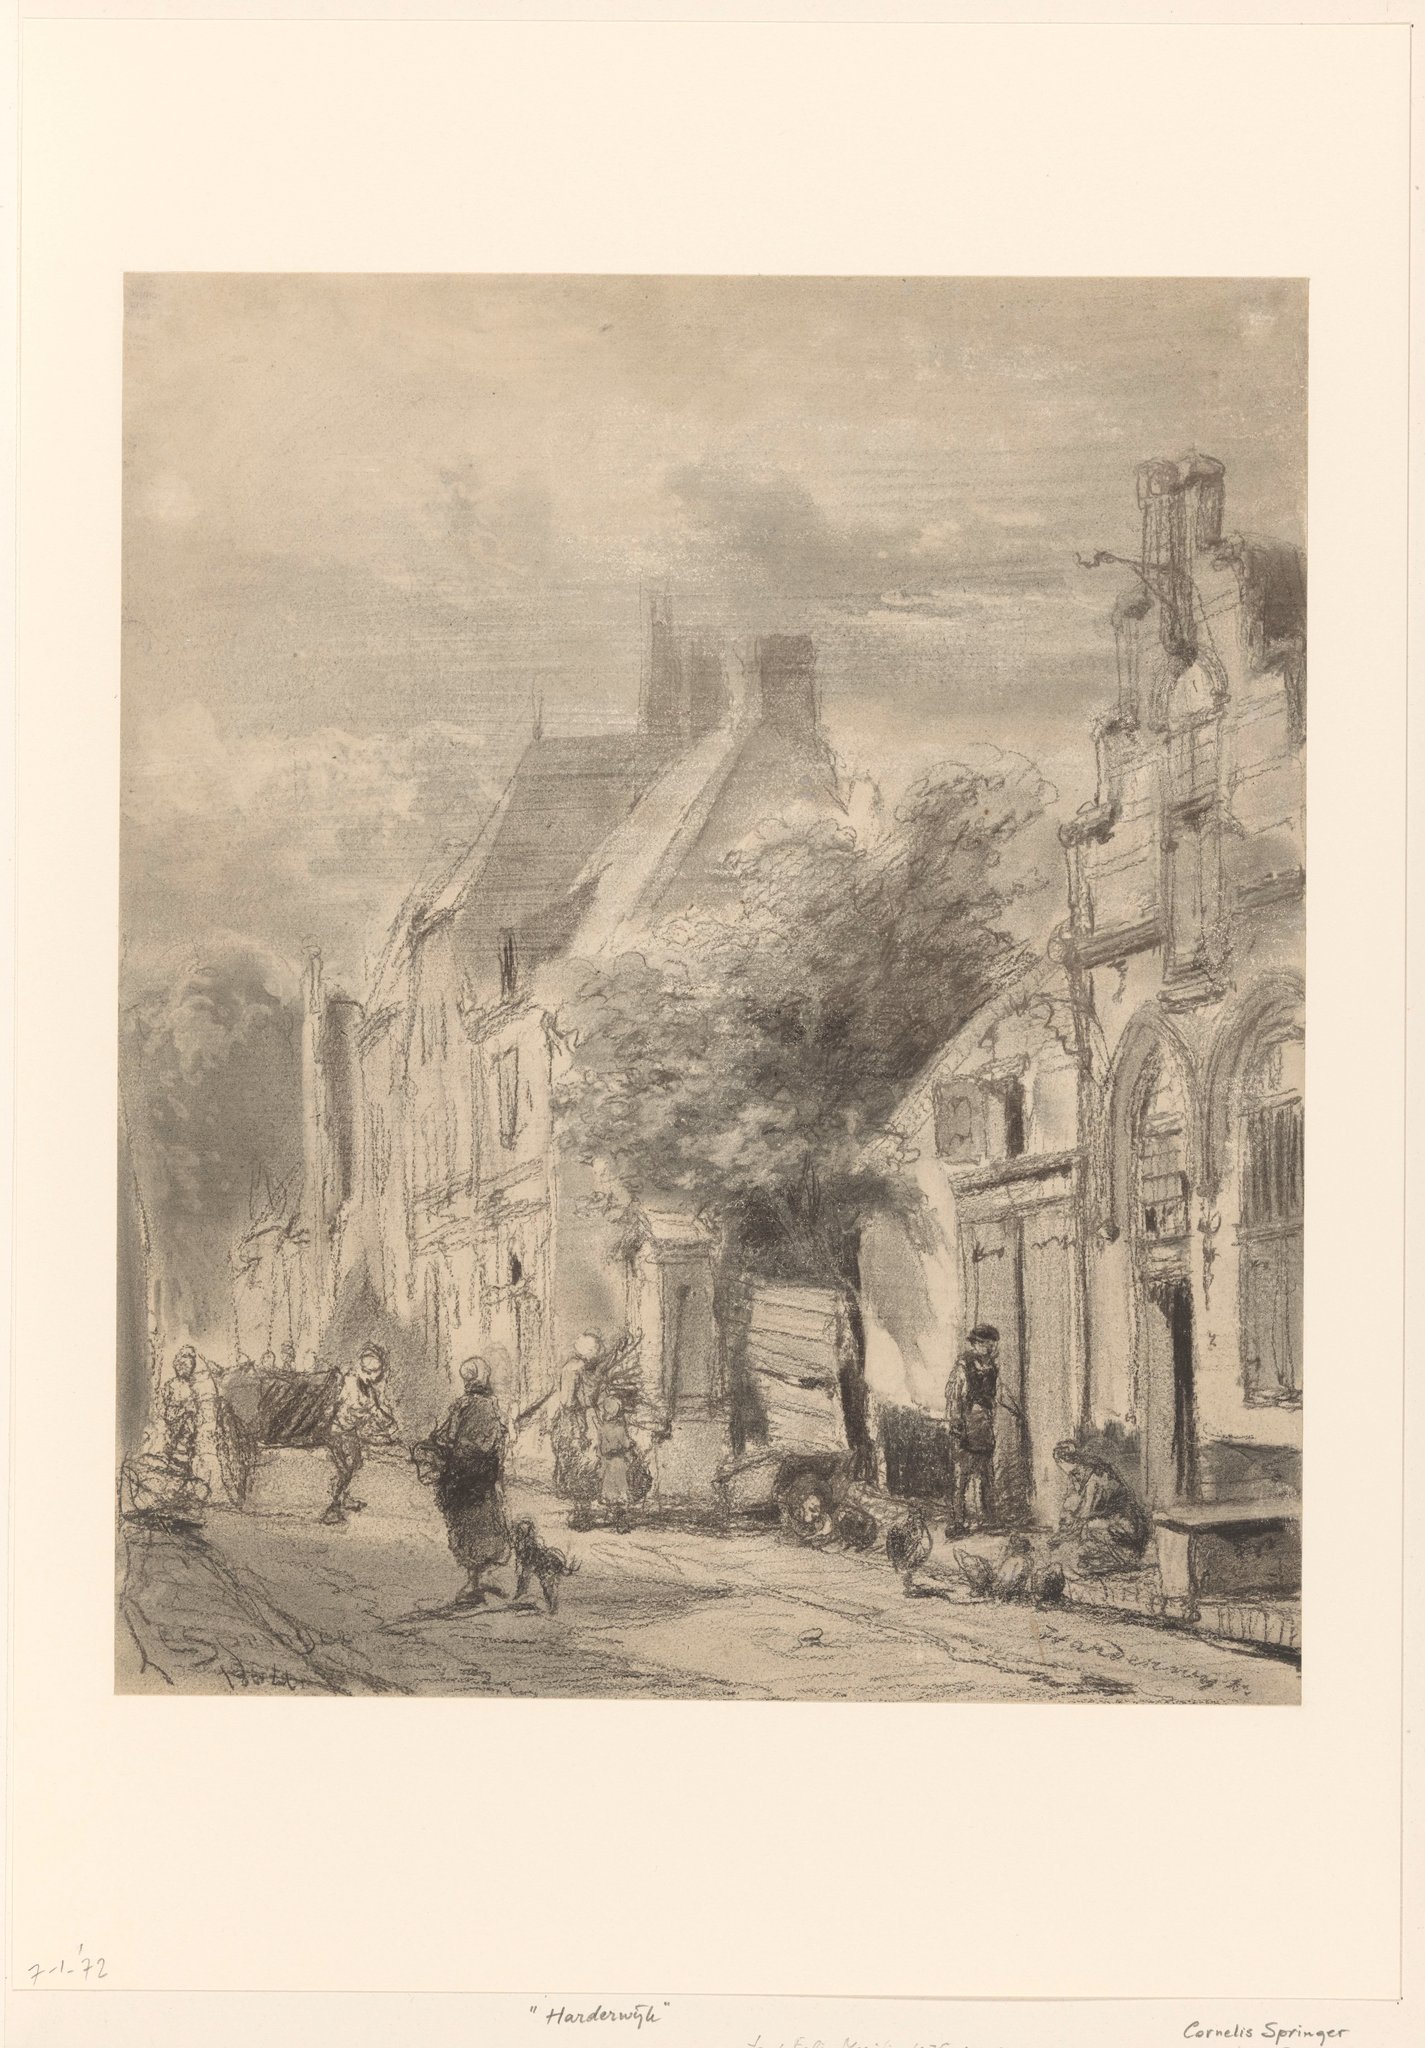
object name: drawing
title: Straatgezicht in Harderwijk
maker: cornelis springer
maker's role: draughtsman, painter, print maker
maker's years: 1817-1891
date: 1864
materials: chalk, paper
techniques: brush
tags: village street